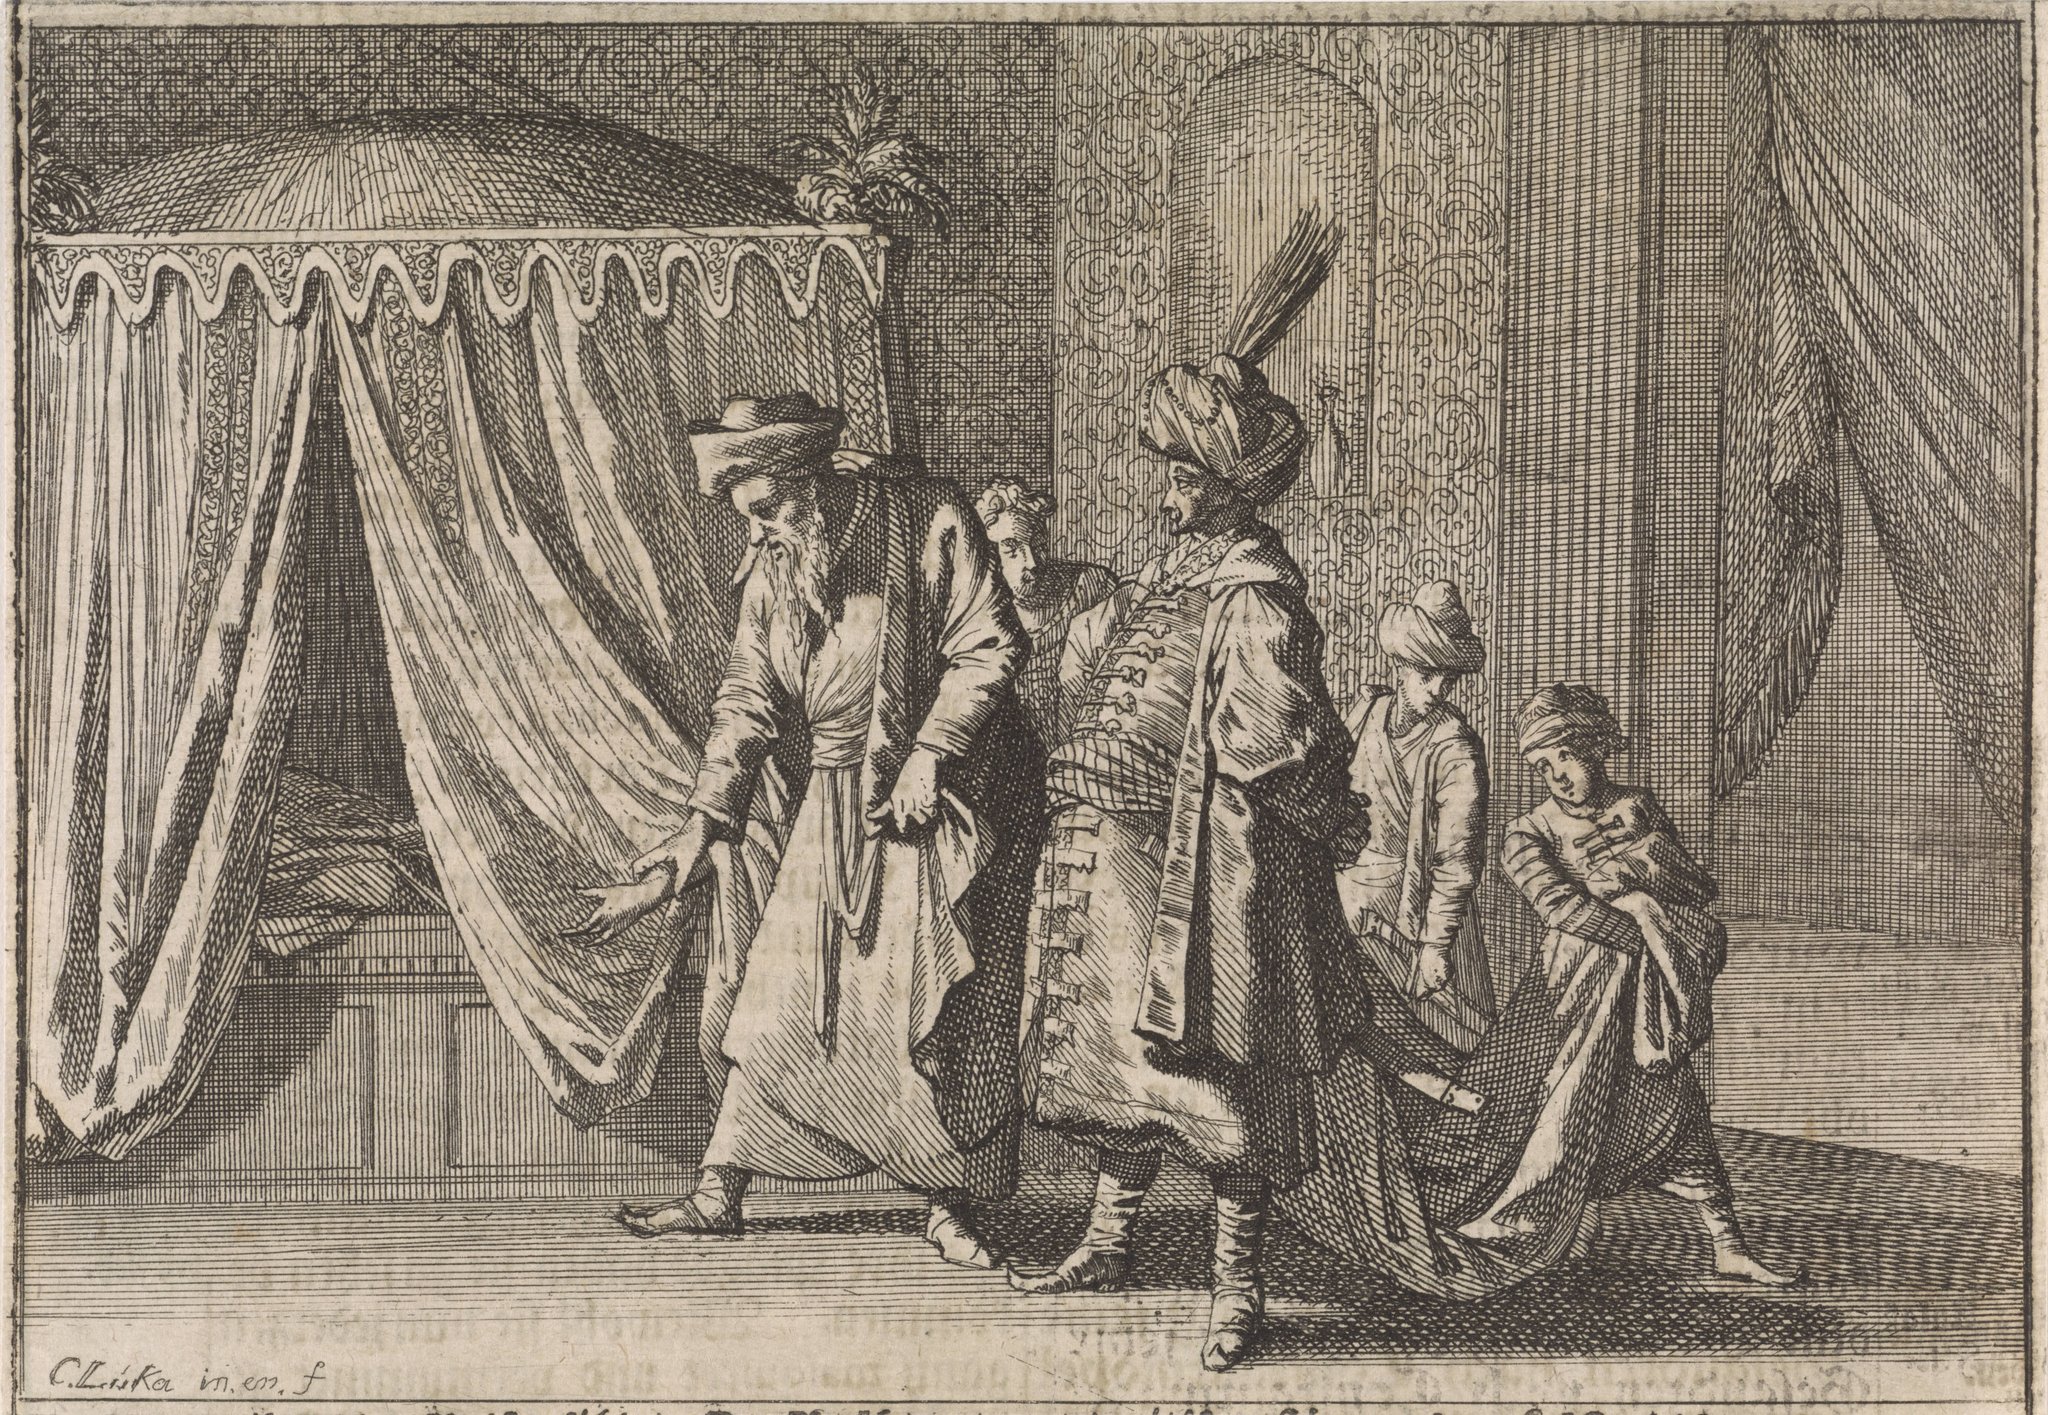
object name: book illustration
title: Ziekbed van de vrouw van de pasja, 1639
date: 1701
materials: paper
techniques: etching, letterpress printing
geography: frankfurt am main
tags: sick-bed, physician, doctor, healing of sick person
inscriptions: collector's mark: Lugt 2228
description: Een vertrek met een hemelbed. Uit het hemelbed steekt de hand van de zieke vrouw van de Pasja van Aleppo. Een geneesheer voelt aan de pols van de vrouw terwijl de pasja toekijkt.